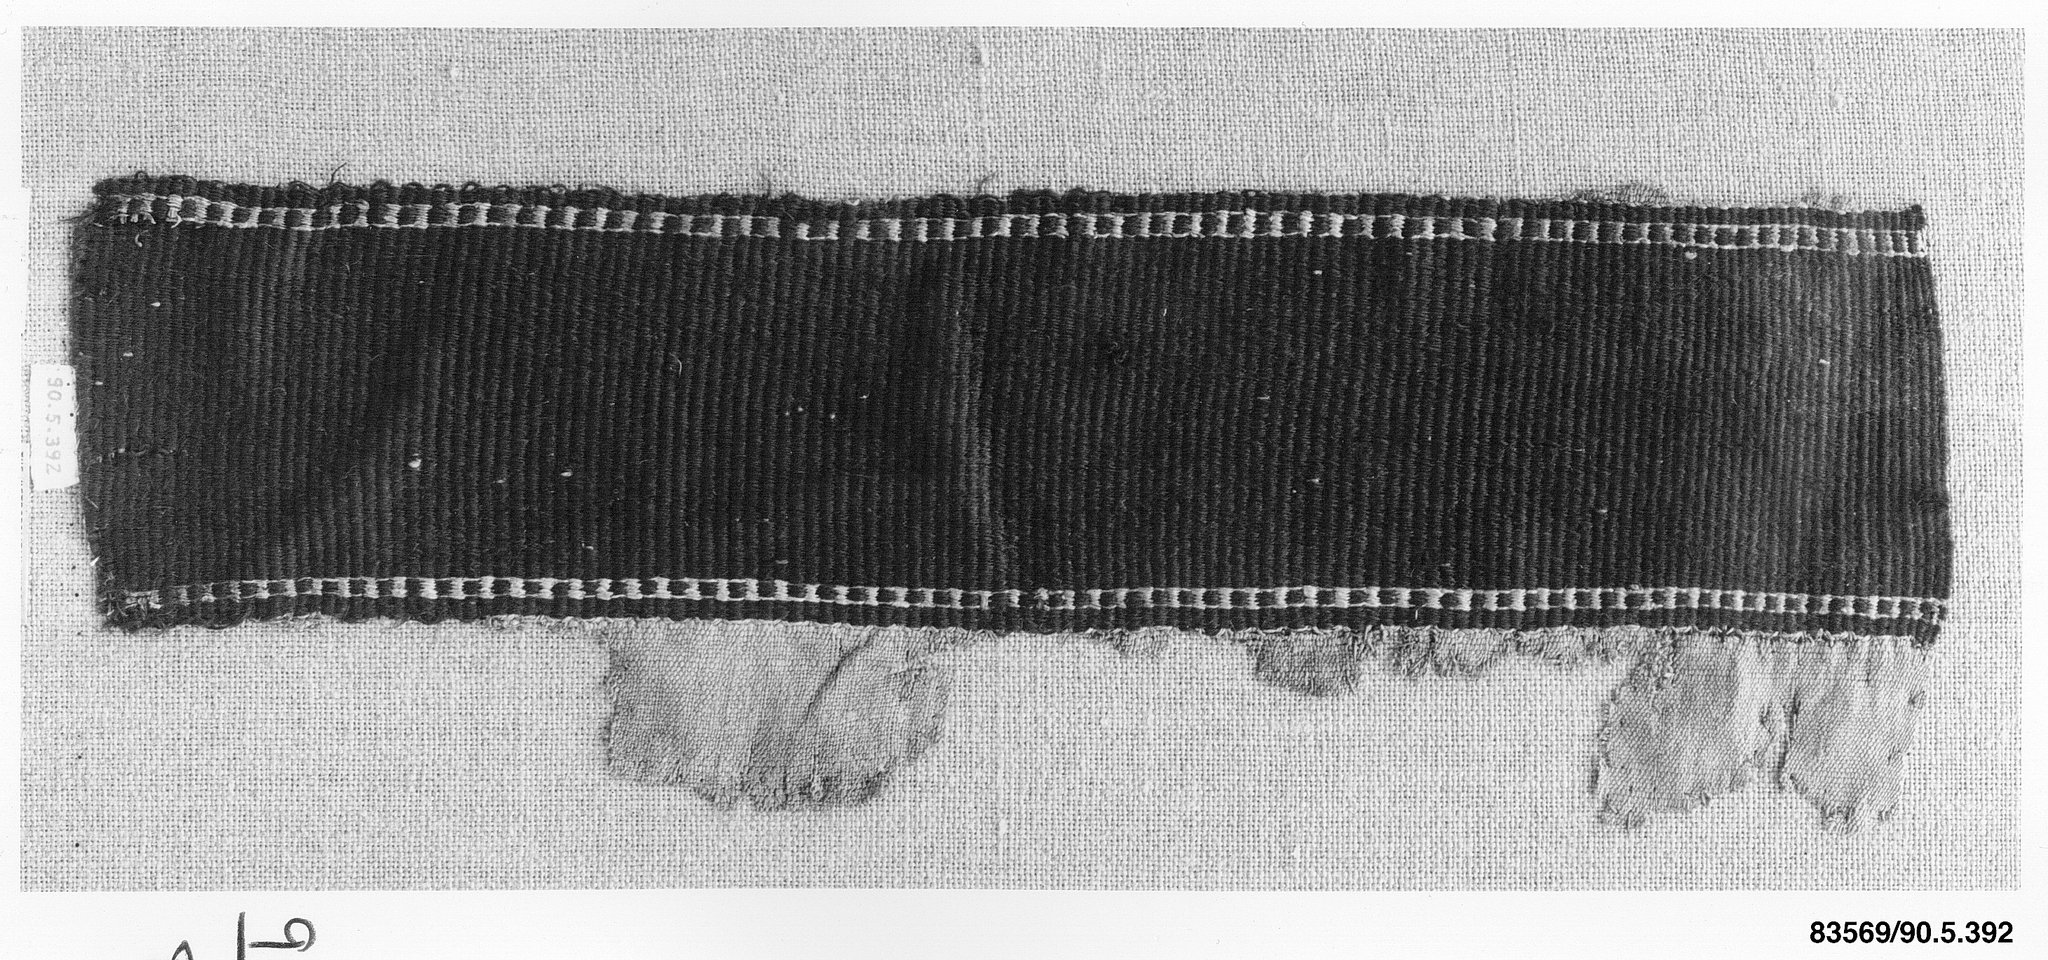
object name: textile fragment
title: Fragment of a Shoulder Band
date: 201-300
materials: linen, wool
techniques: weave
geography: egypt